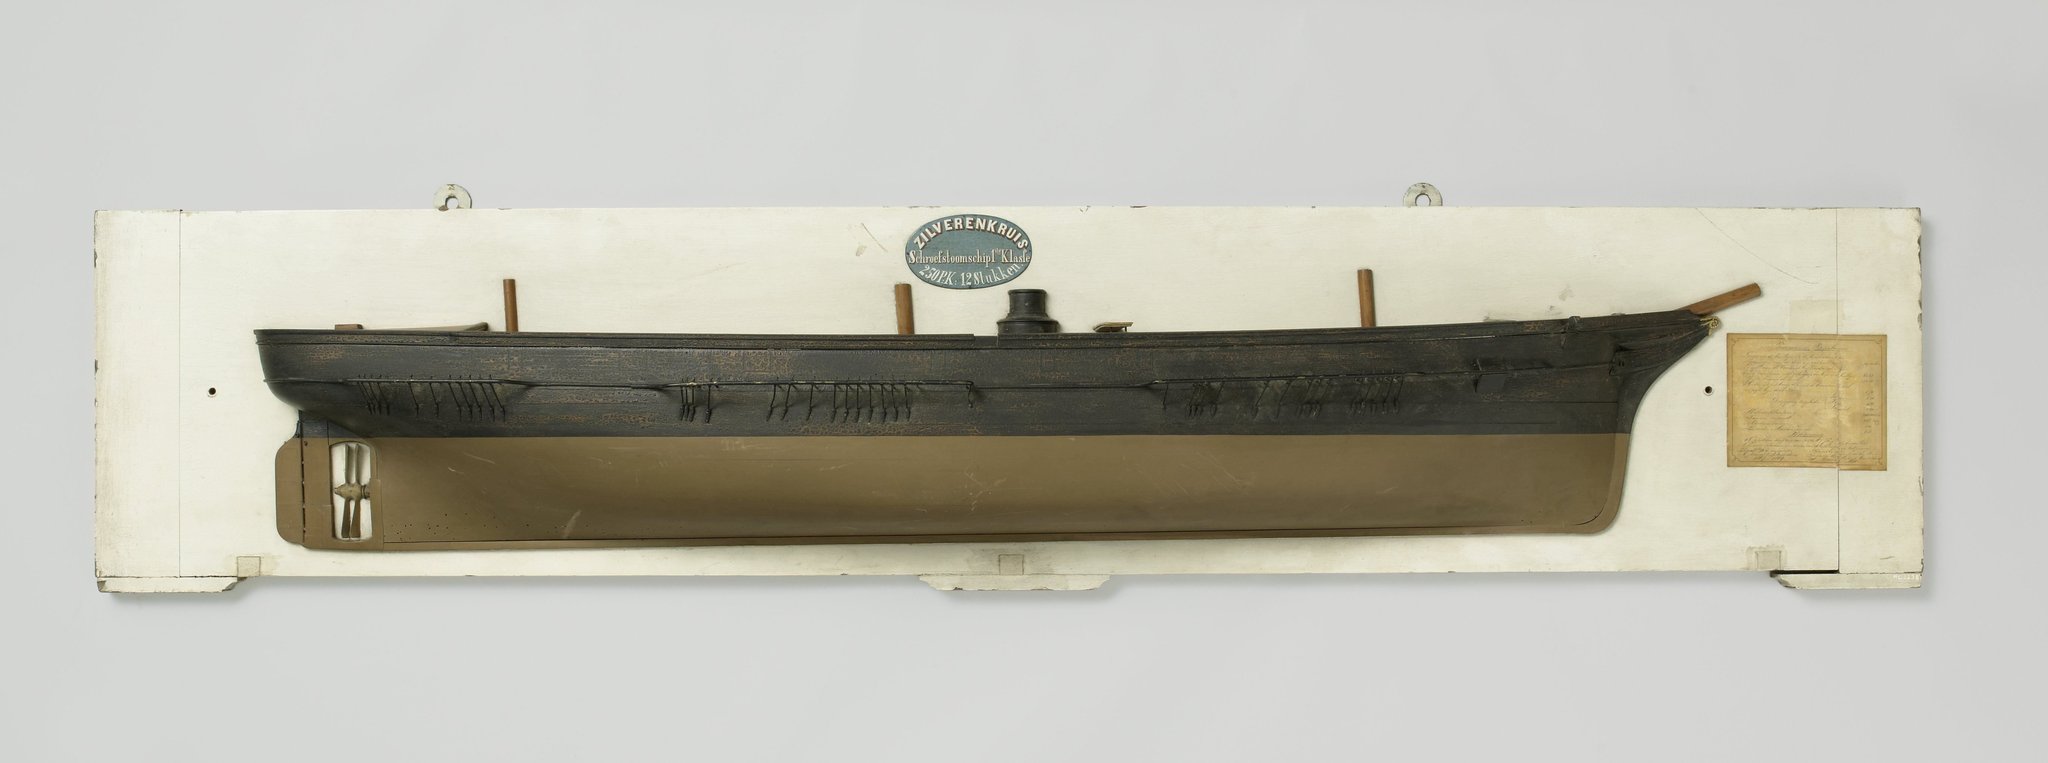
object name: ship model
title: Half Model of a Screw Steamer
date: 1868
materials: brass, wood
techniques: polychromy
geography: amsterdam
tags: zilveren kruis (schip)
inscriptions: inscription, top centre, on an oval blue label: ‘ZILVEREN KRUIS / Schroefstoomschip 1ste Klasse / 250 P:K: 12 STUKKEN.’, inscription, centre right, on a piece of paper, in ink: ‘Voornaamste Bepalingen / [followed by measurements and armament]’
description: Gepolychromeerd en volledig beplankt mallenmodel (stuurboord) van een driemast schroefstoomschip, met negen grote en twee kleine poorten. Bijna verticale, rechte voorsteven met galjoen en krul als schegbeeld, composiet kraanbalk. Elliptisch hek met Rijkswapen, Mangin-schroef en roer met roerkap. Het model heeft een kort bakdek, klein campanjedek en een brug dwars over het hoofddek vlak voor de uitschuifbare schoorsteen. Het model is voorzien van alle rusten met puttings. De zeeg is bijna vlak, een reehout. Rondspant. Schaal 1:50 (schaal op model).